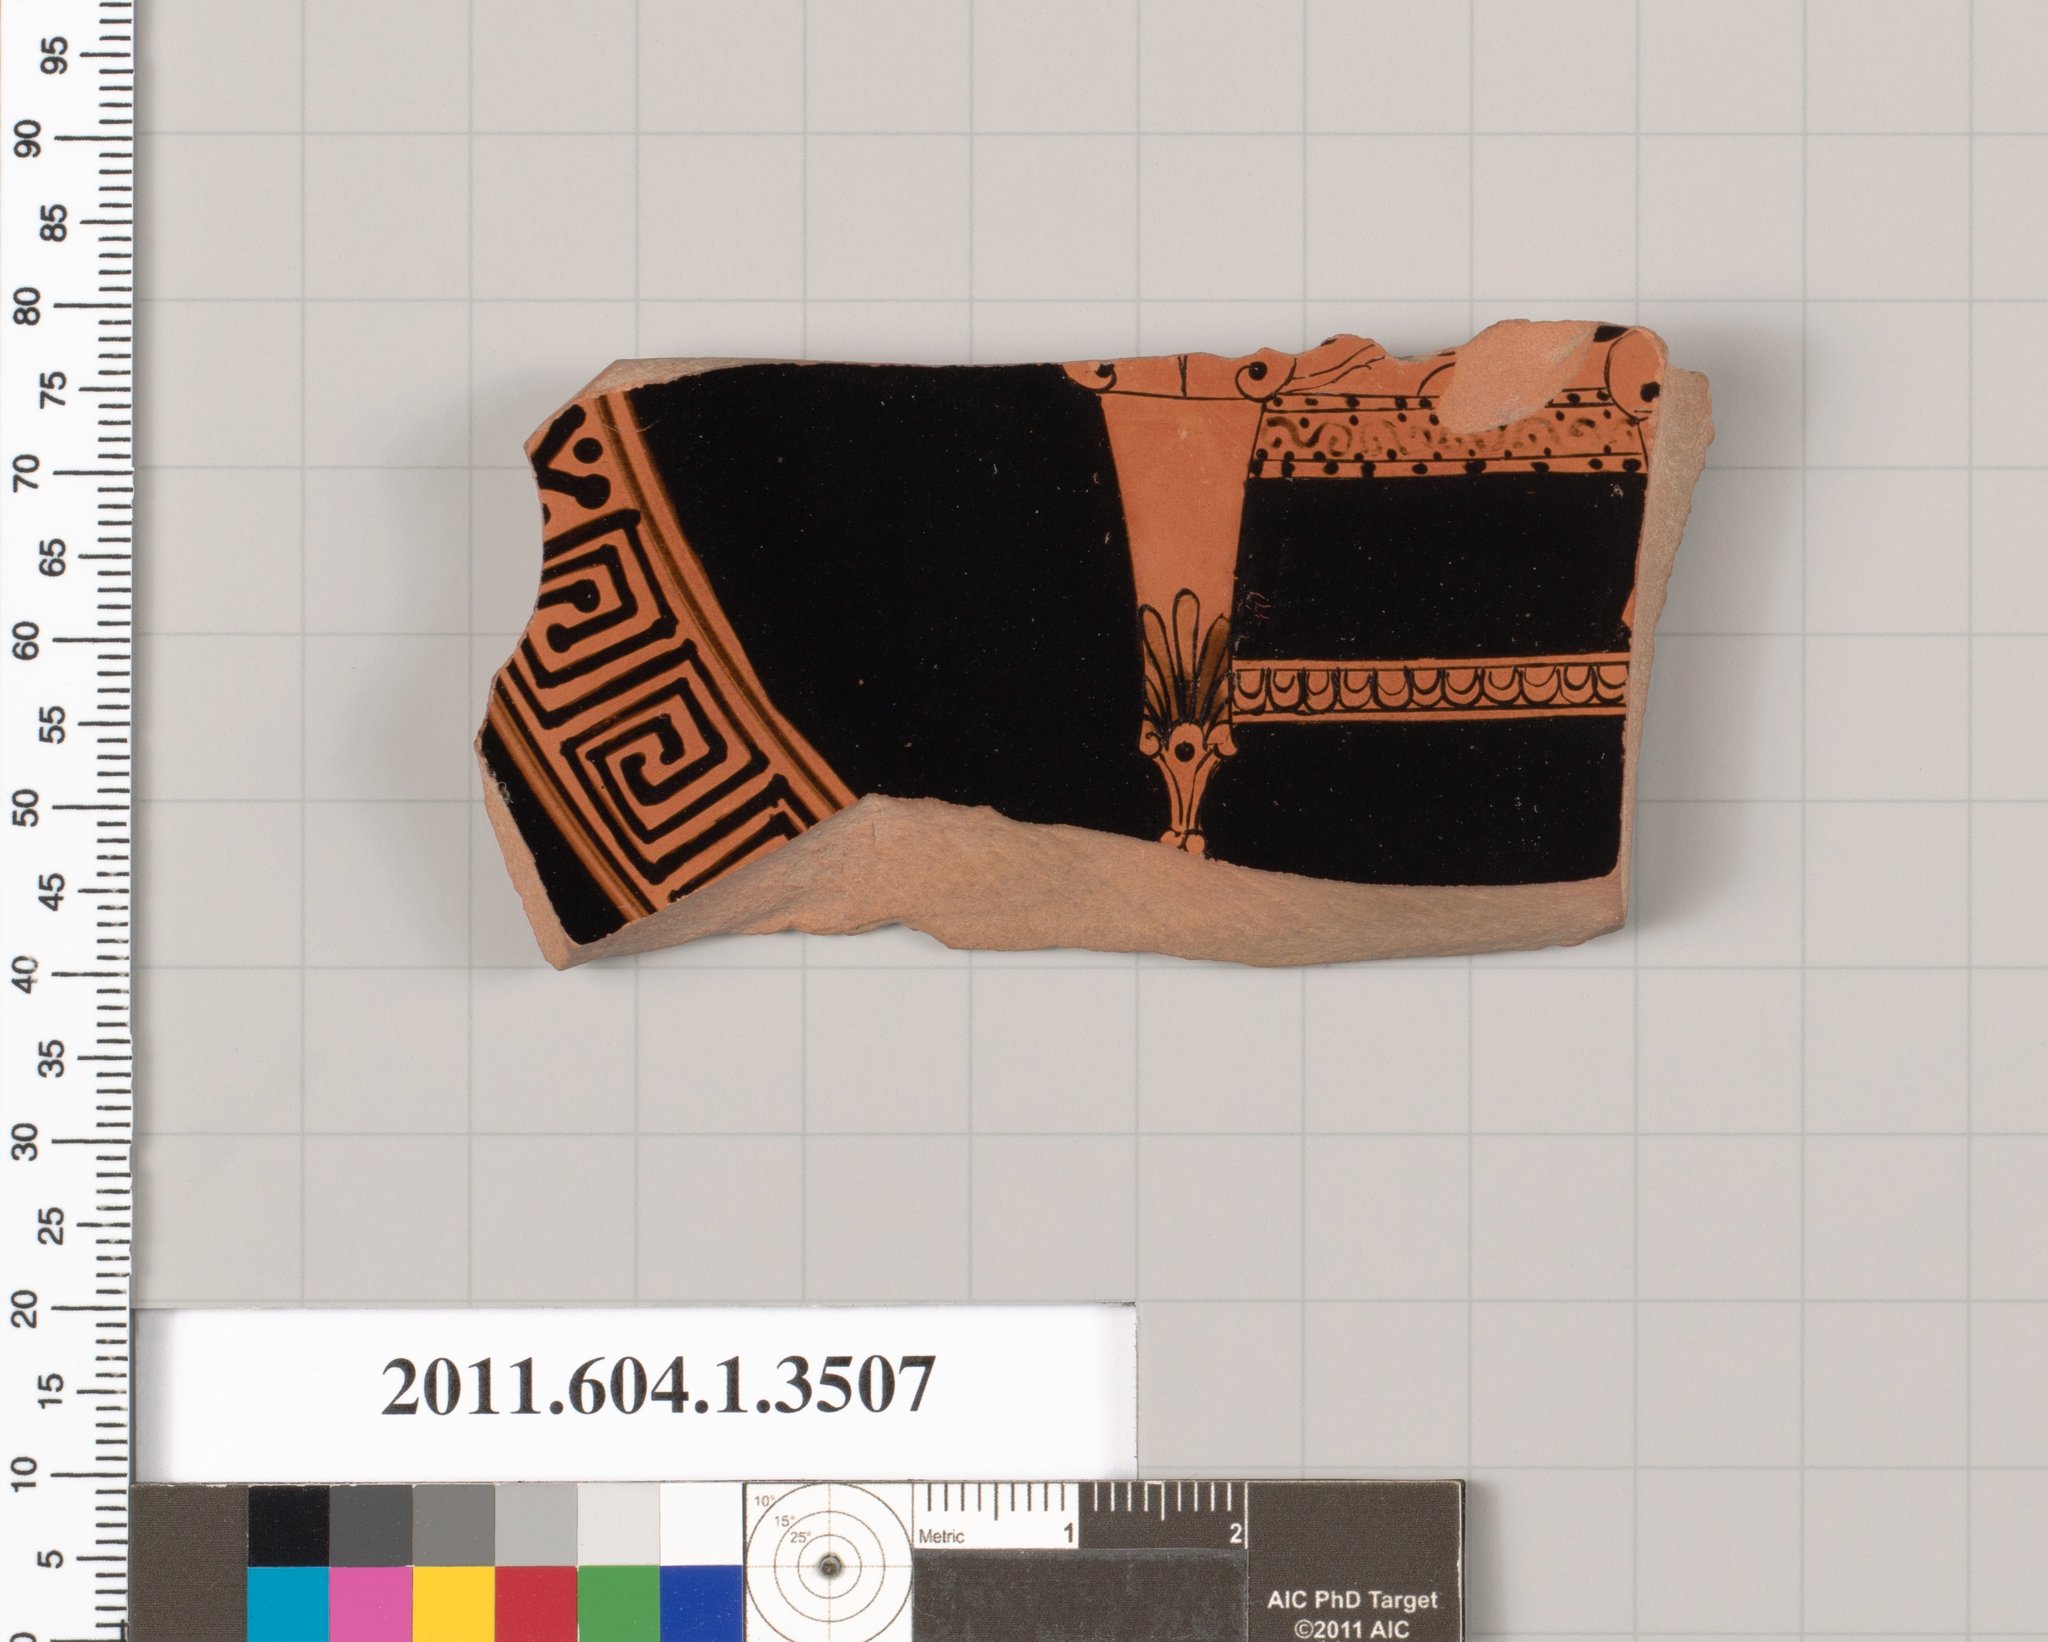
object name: kylix fragment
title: Terracotta fragment of a kylix (drinking cup)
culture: greek, attic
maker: painter of london e 80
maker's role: artist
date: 490-480 BCE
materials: terracotta